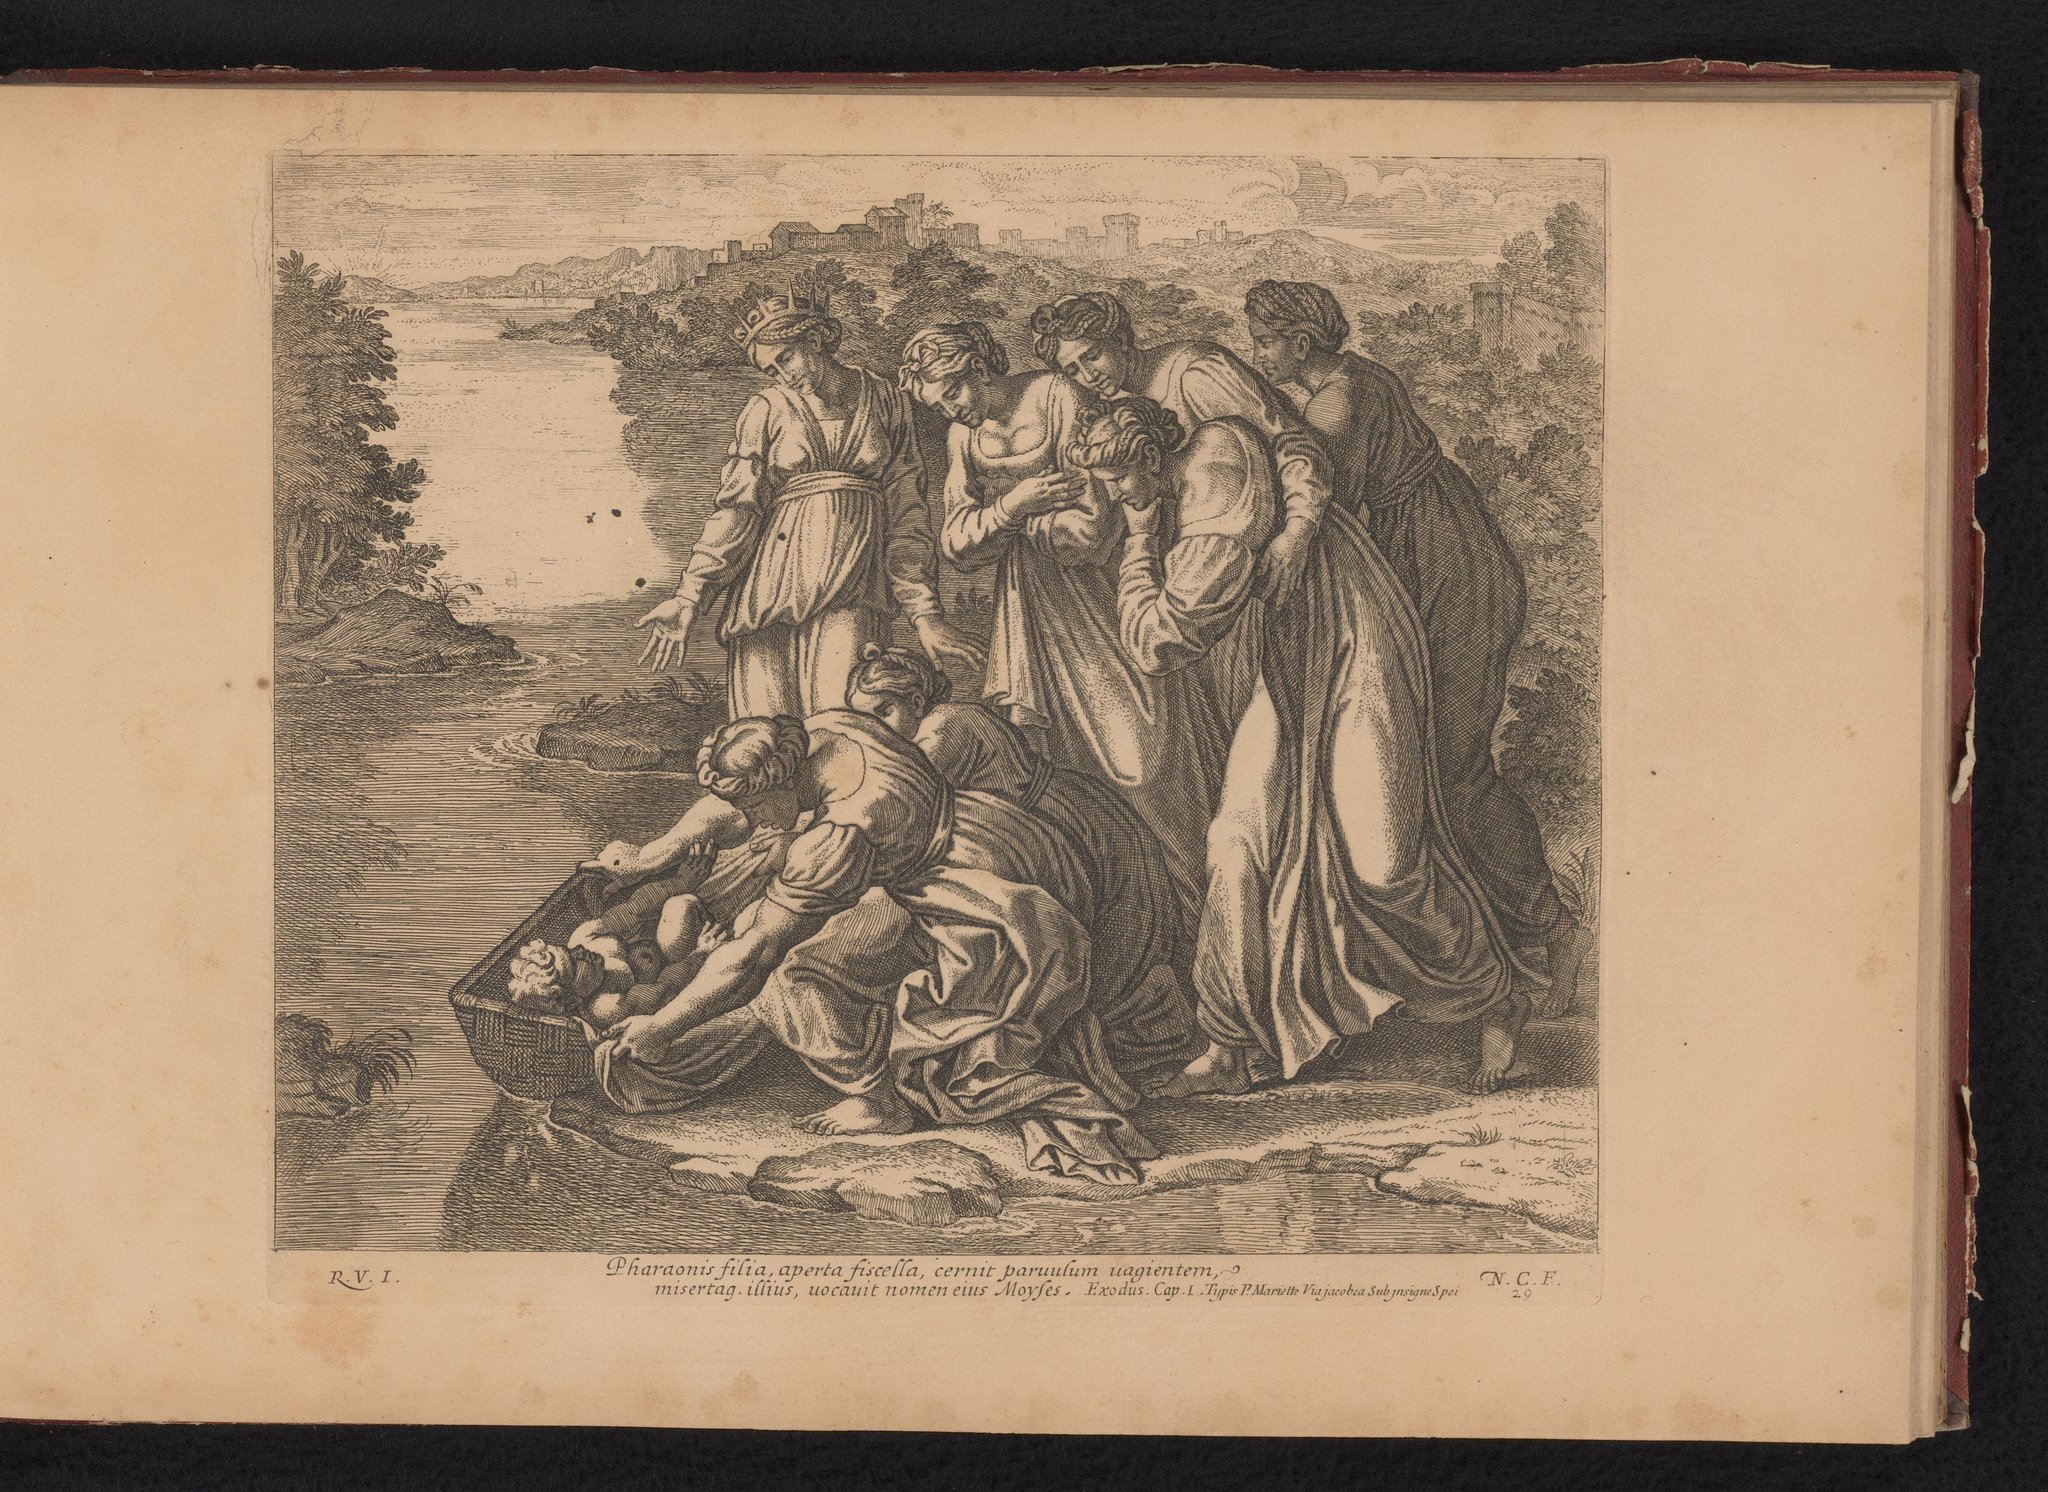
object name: print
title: Sacrae historiae acta a Raphael Urbin in Vaticanis xystis ad picturae miraculum expressa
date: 1649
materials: paper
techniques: etching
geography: paris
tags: moses is pulled out of the water by the servants, the finding of moses: pharaoh's daughter comes to bathe with her maidens in the river and discovers the child floating on the water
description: Deze prent maakt deel uit van een album.